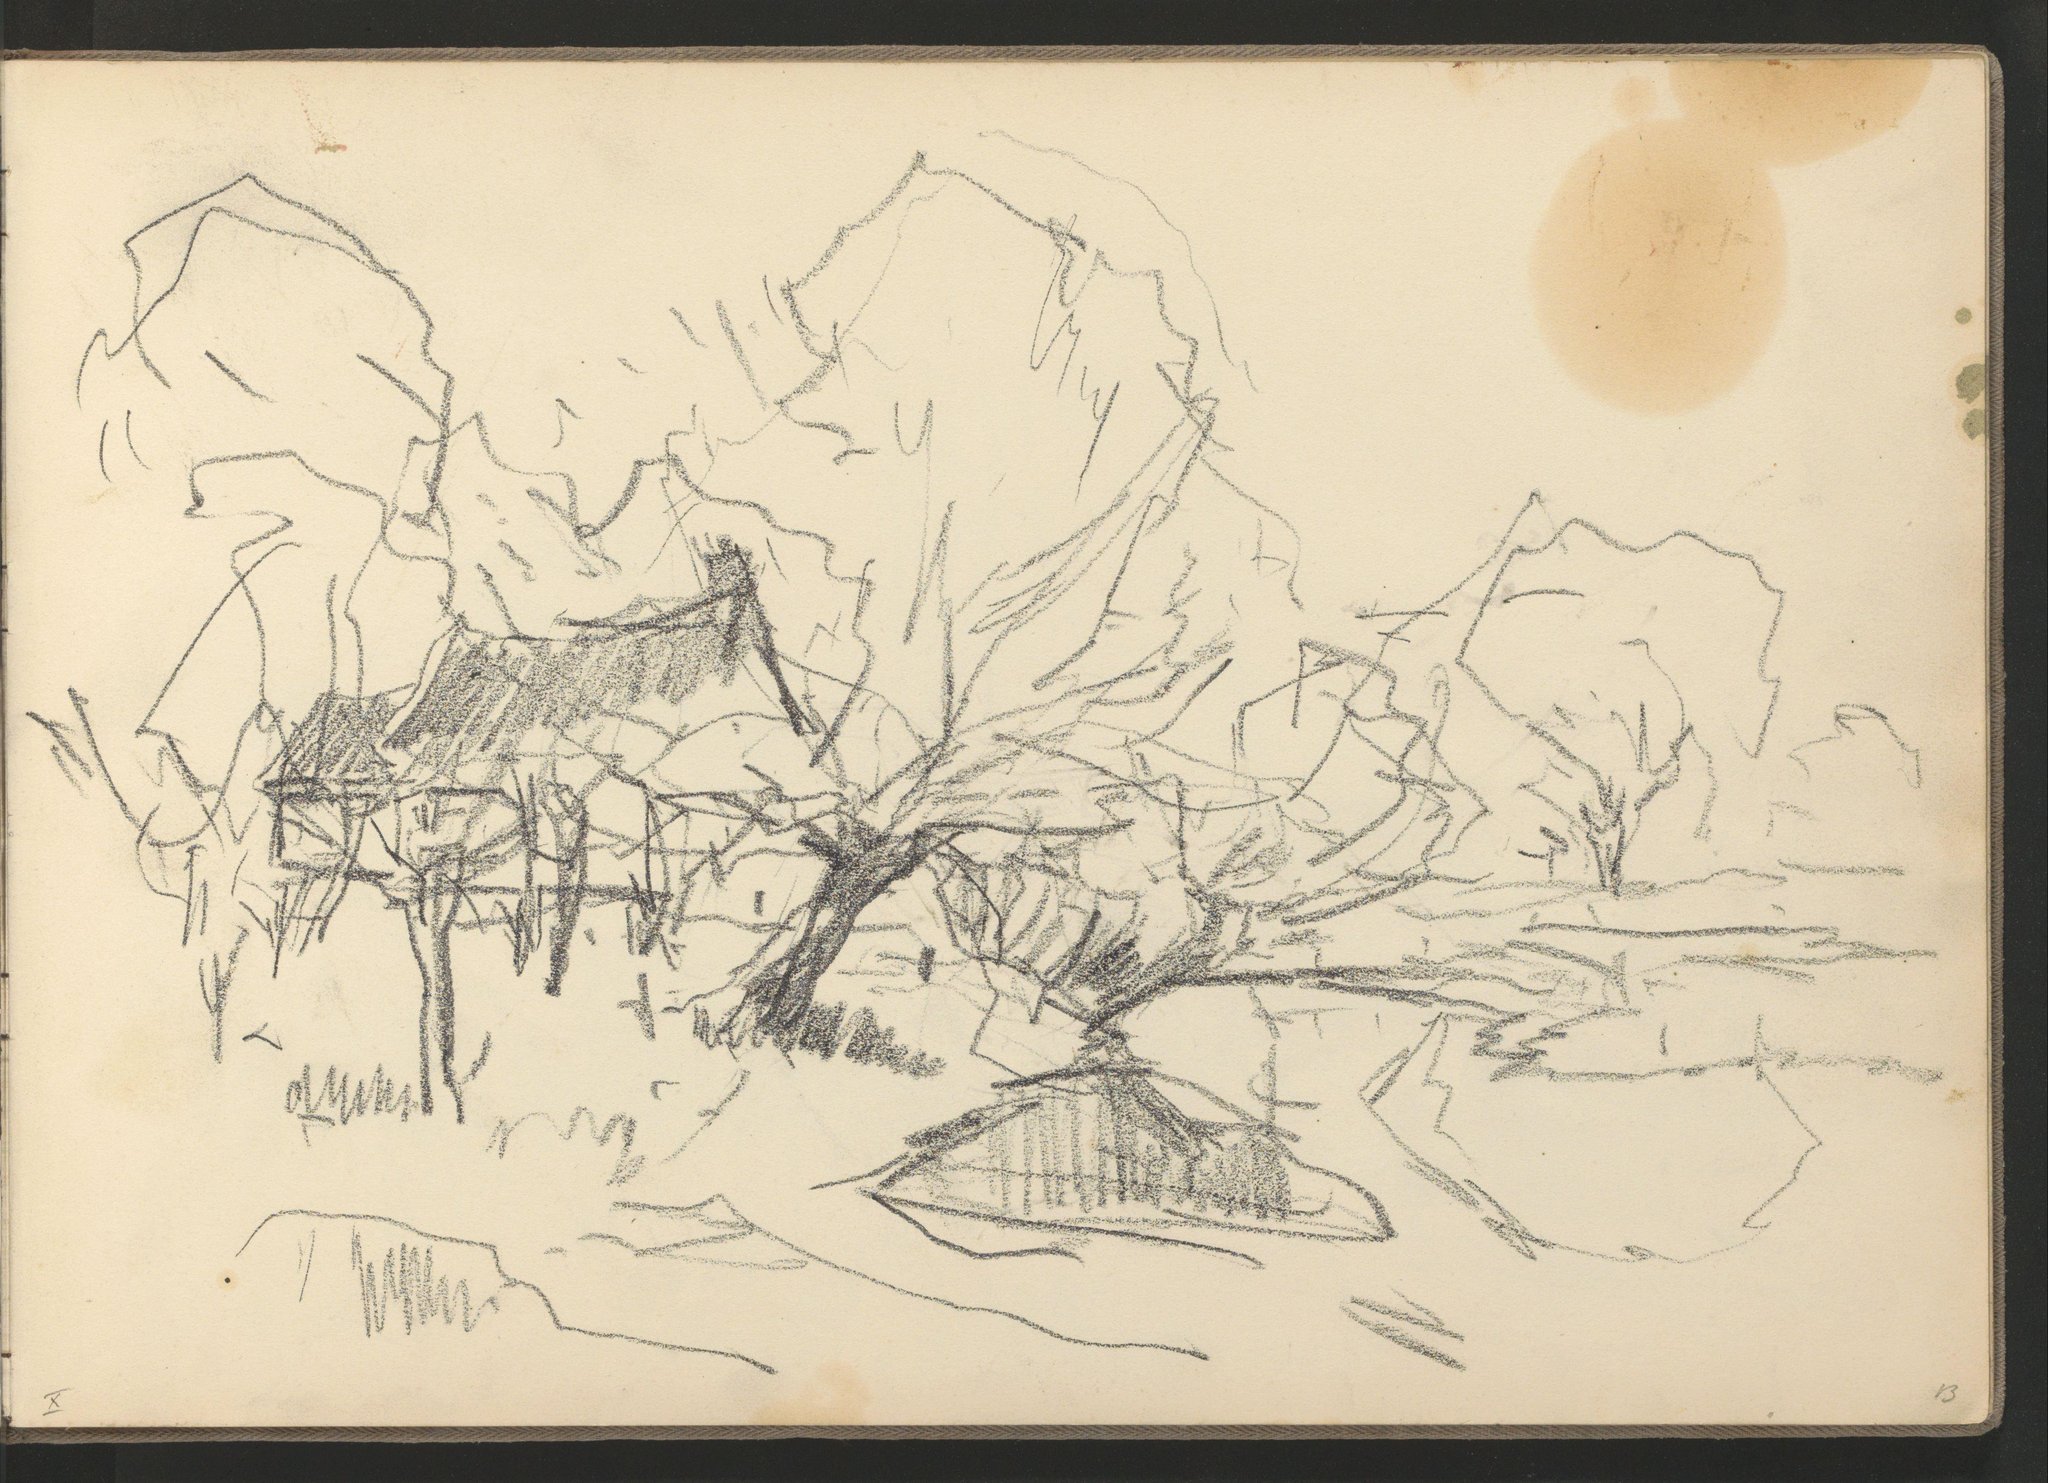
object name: sketchbook leaf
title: Landschap met bomen en een huis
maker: egbert rubertus derk schaap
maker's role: draughtsman, painter, print maker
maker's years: 1862-1939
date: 1891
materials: paper, pencil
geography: north holland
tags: trees, farm or solitary house in landscape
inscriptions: number: ‘X’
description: Pagina 13 uit een schetsboek met 64 pagina's.